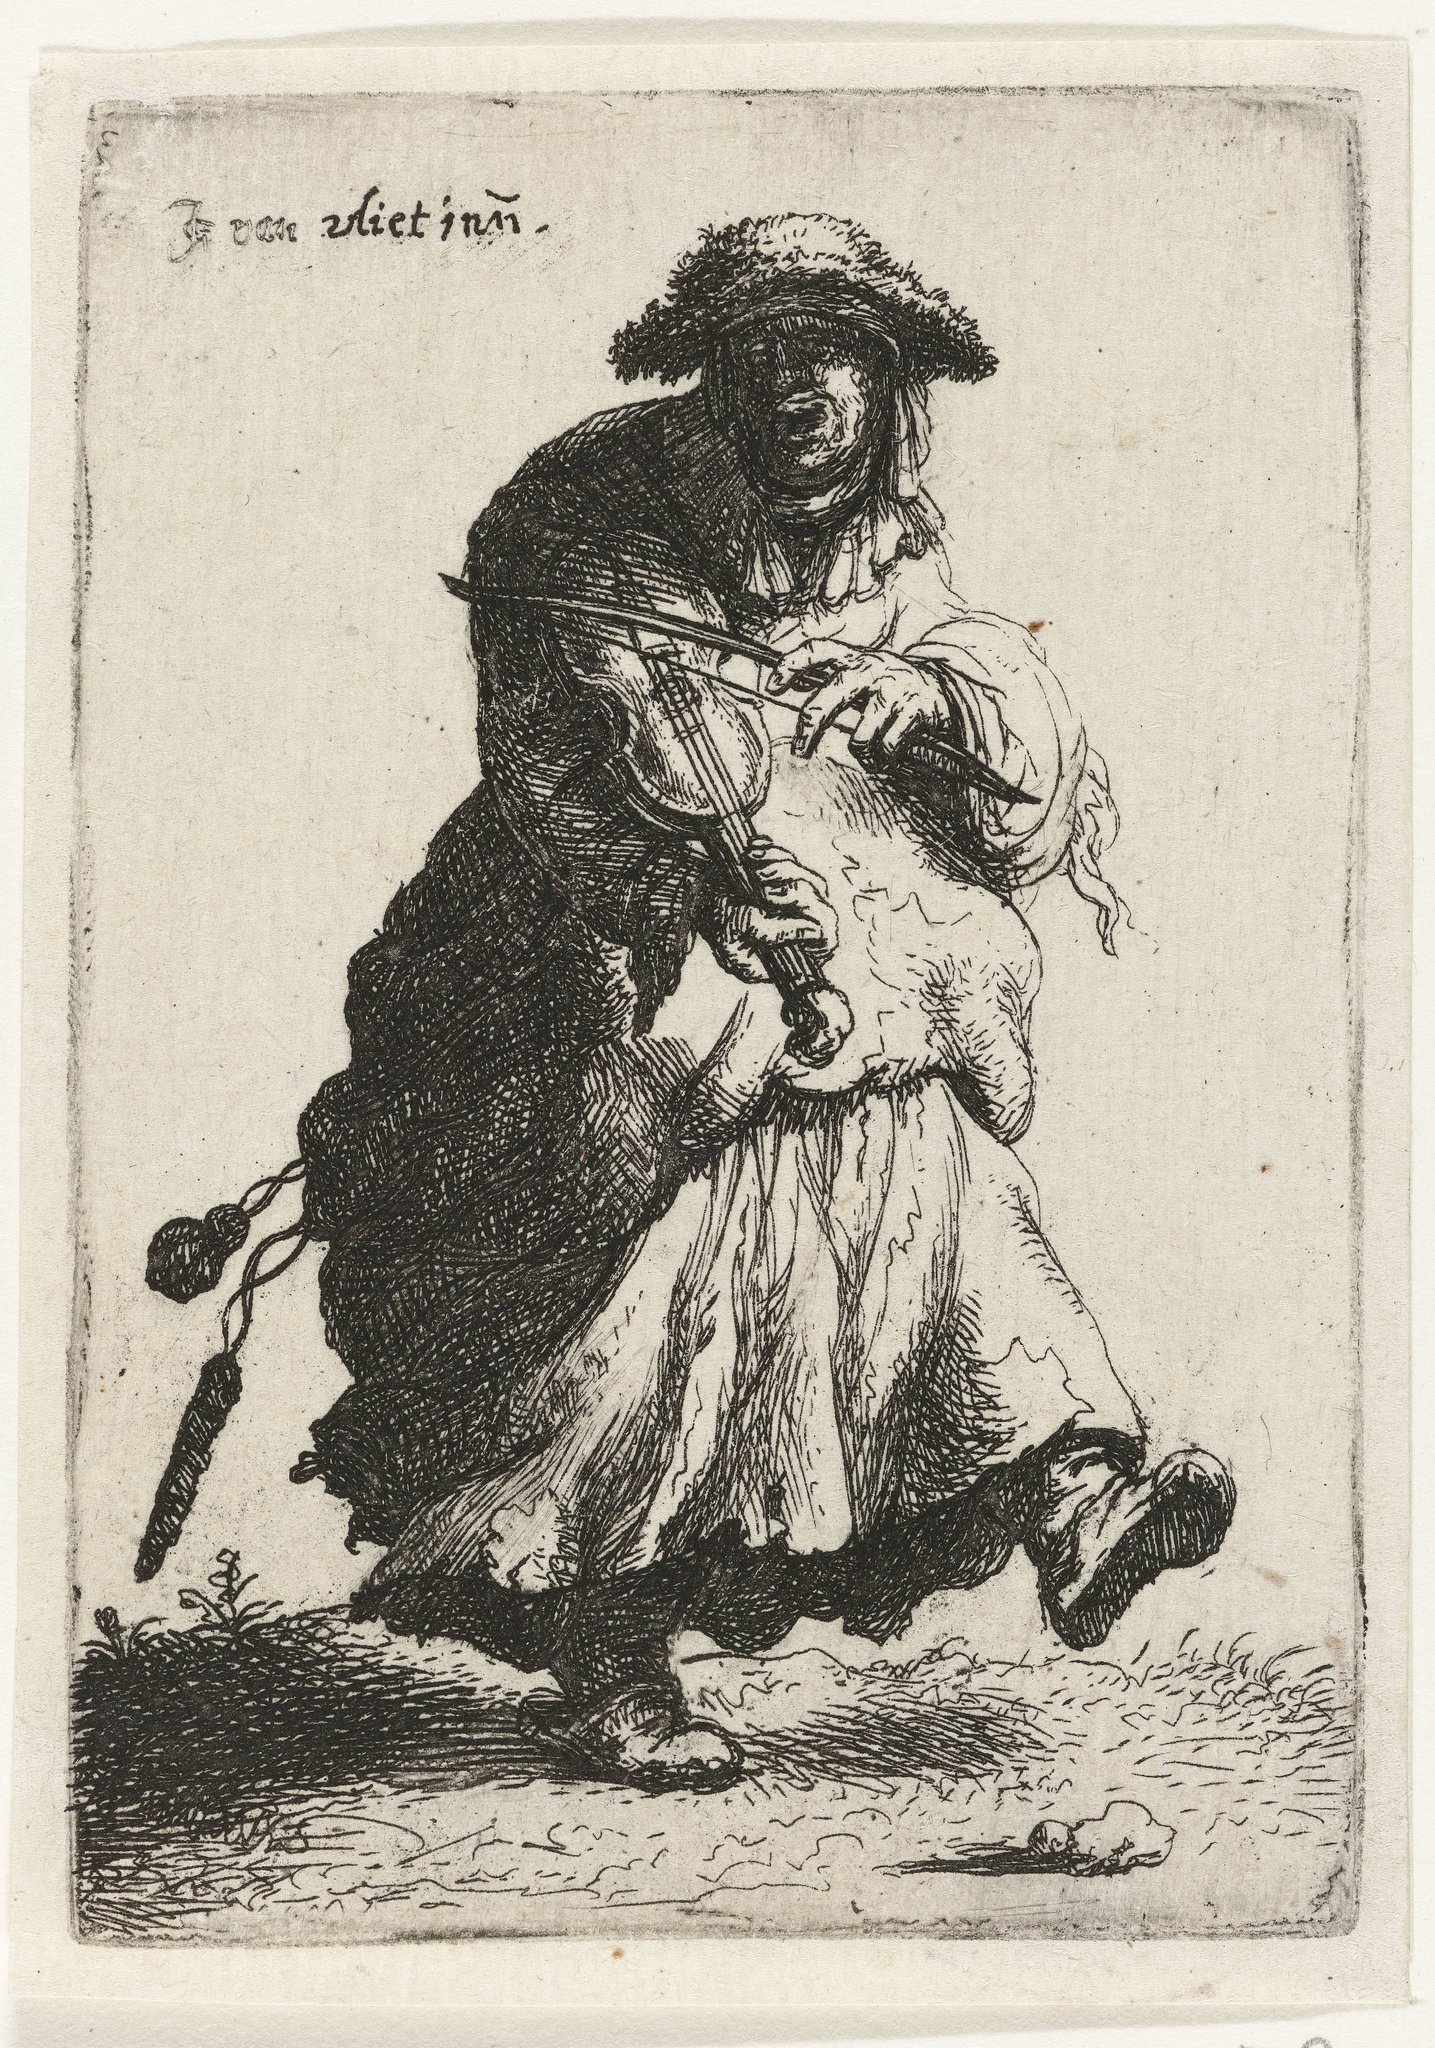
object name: print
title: Bedelaars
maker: jan gillisz. van vliet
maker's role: draughtsman, painter, print maker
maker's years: 1600-1668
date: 1632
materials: paper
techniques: etching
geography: leiden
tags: violin, fiddle - cc - out of doors, beggar, instrumental popular music - cc - out of doors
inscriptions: collector's mark: Lugt 240